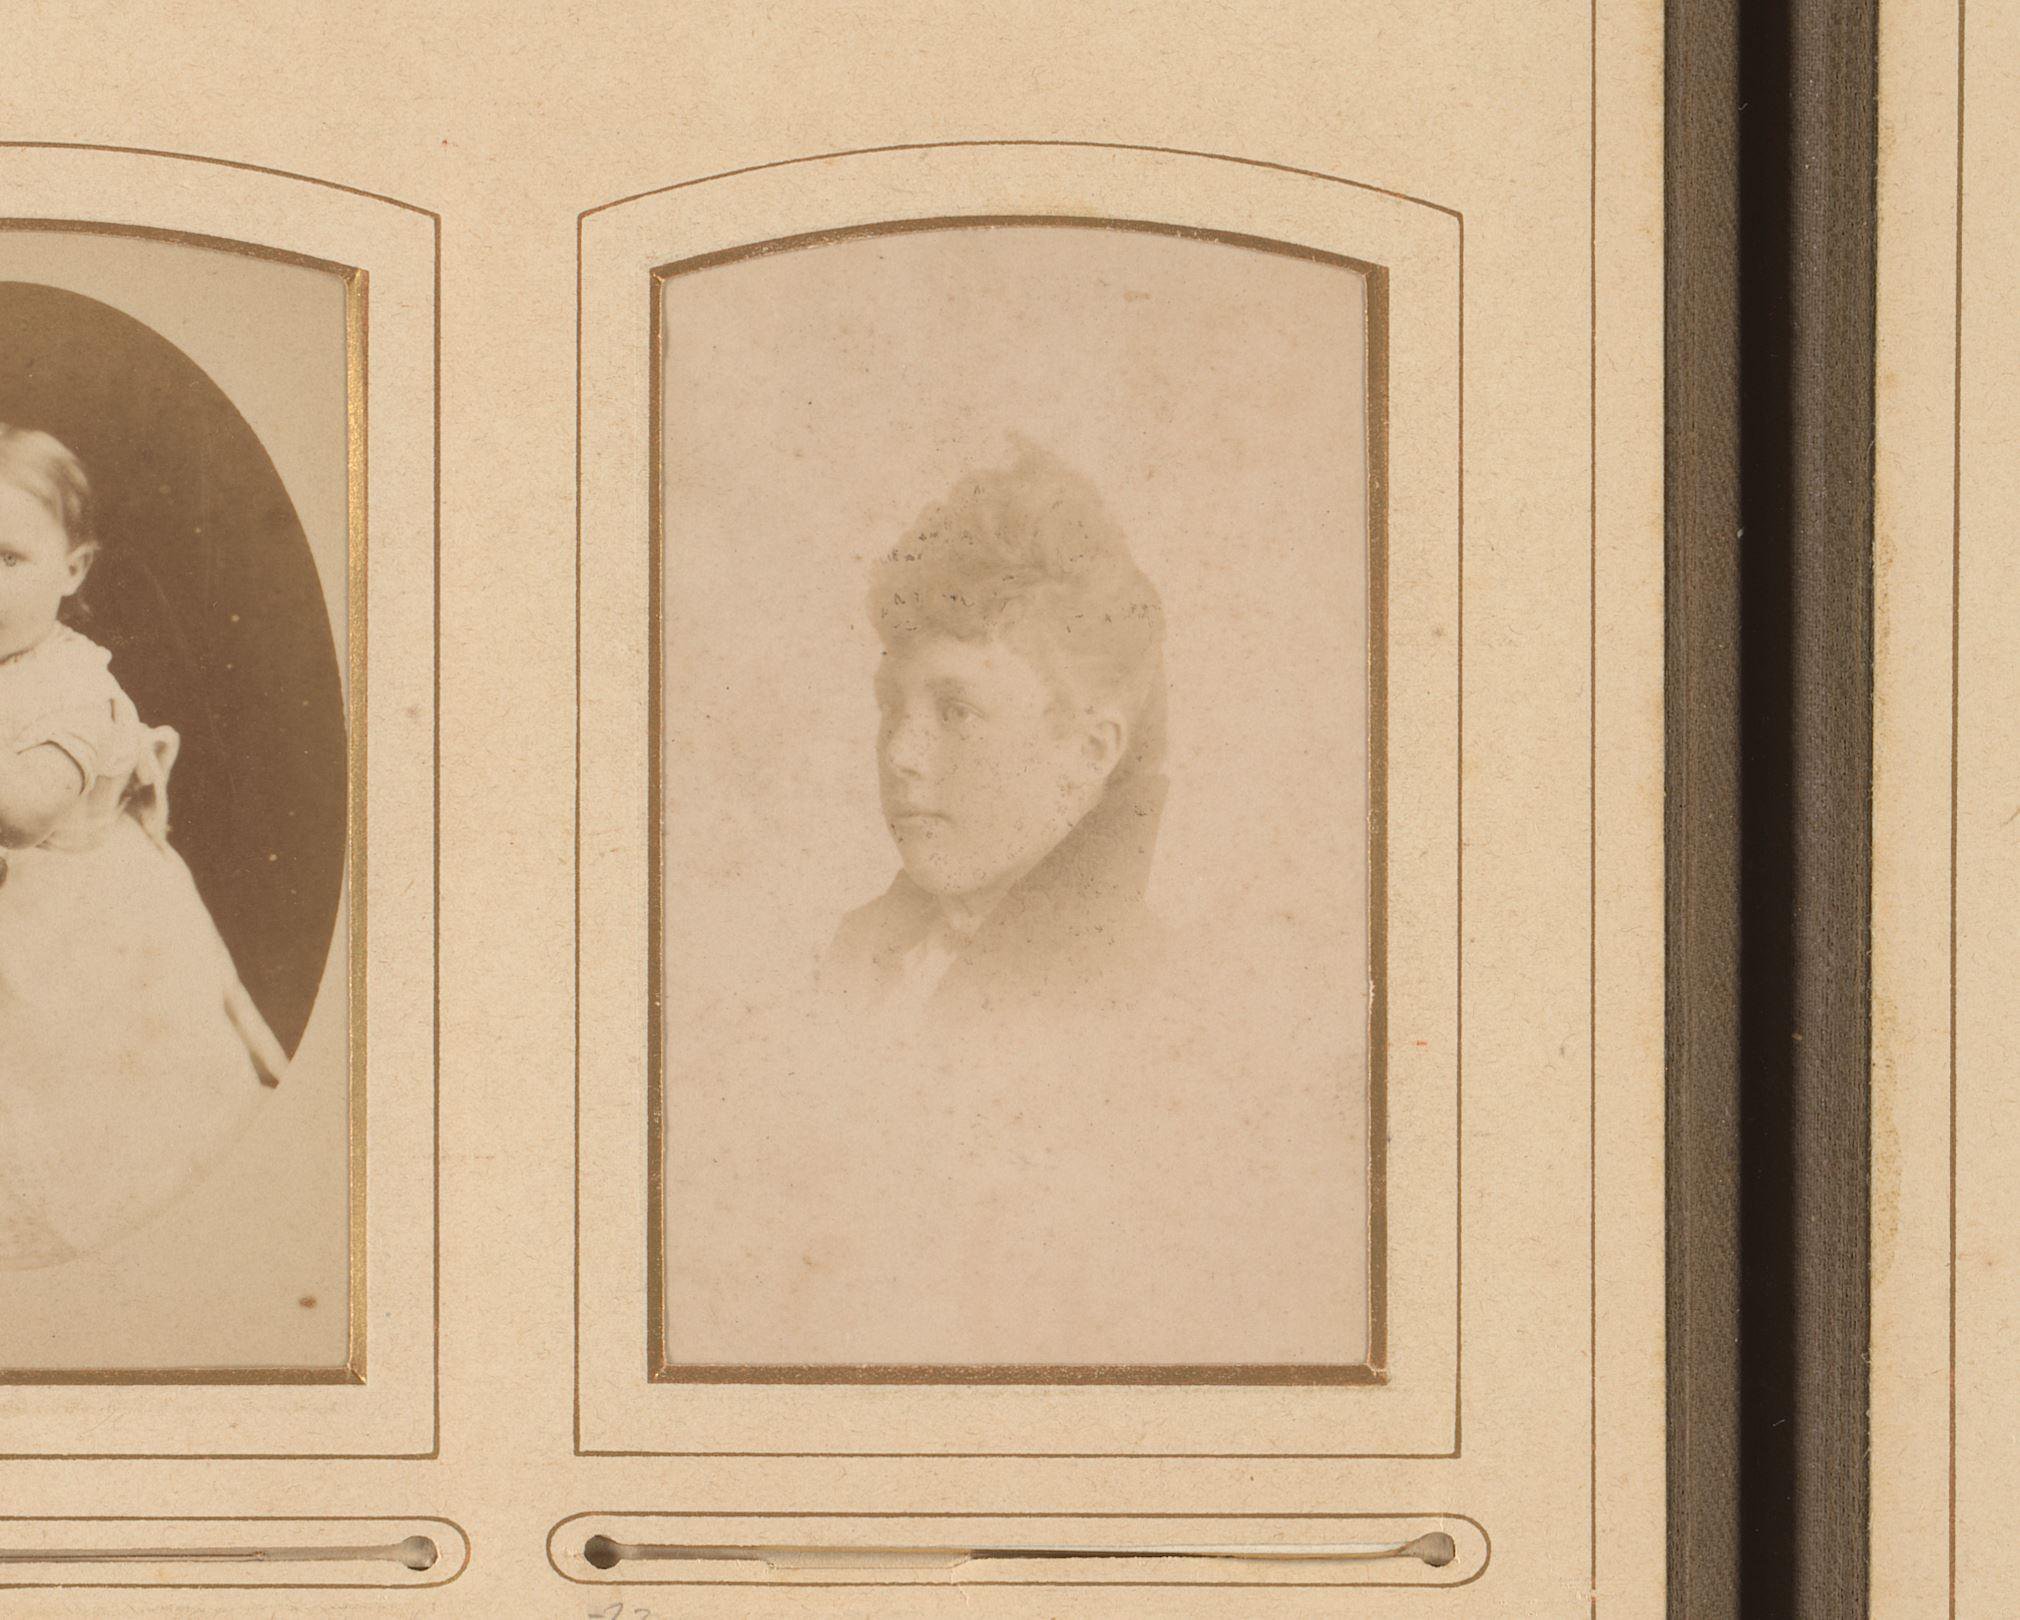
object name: carte de visite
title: Portret van een onbekende vrouw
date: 1880-1890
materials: cardboard, paper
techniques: albumen print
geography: amsterdam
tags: anonymous historical person portrayed - bb - woman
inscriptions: address: ‘Photographie/ Française/ 147/ Warmoesstraat/ AMSTERDAM.’